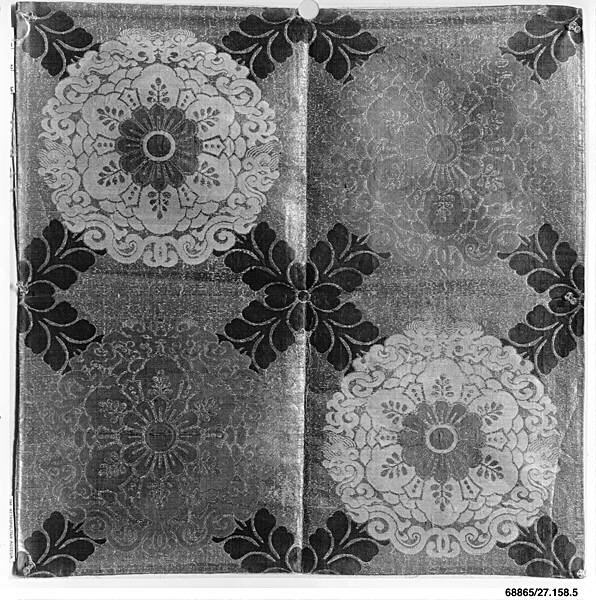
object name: altar cloth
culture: japanese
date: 1701-1800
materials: metal thread, silk